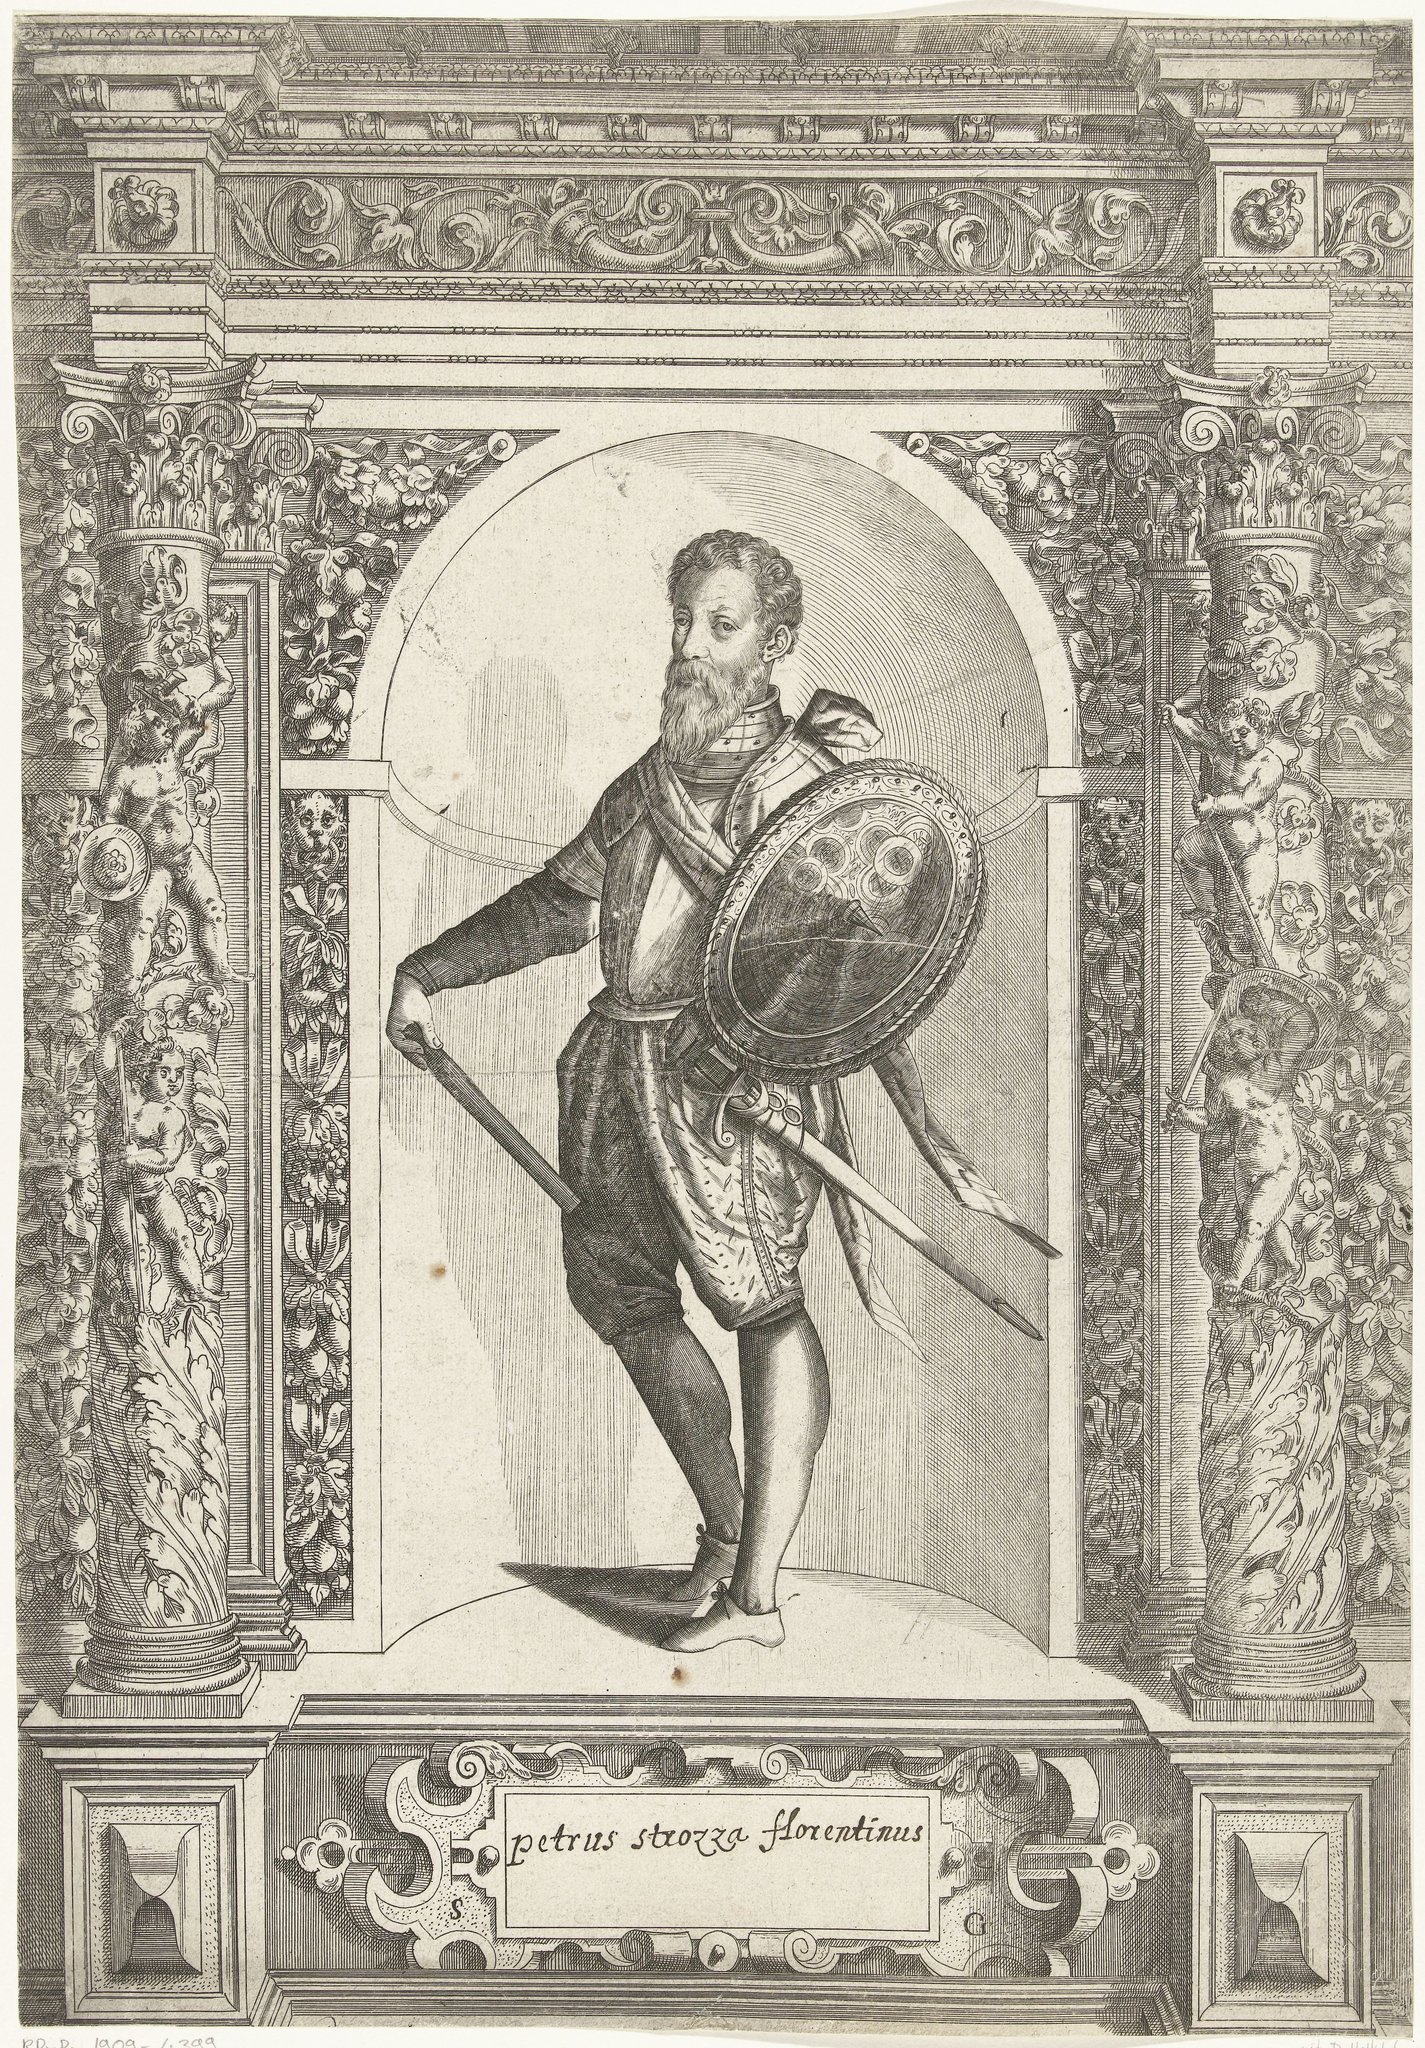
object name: print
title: Portret van Pietro Strozzi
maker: dominicus custos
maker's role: print maker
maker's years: 1560-1615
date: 1582-1601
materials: paper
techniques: engraving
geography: augsburg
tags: pietro strozzi, armour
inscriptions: collector's mark: Lugt 2228, inscription: ‘Petrus Strozza Florentinus’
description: Illustratie uit: Jacob Schrenck von Notzing.Augustissimorum imperatorum, serenissimorum regum atque archiducum, illustrissimorum principum, necnon comitum, baronum, nobilium, aliorumque clarissimorum virorum ... verissimae imagines & rerum ab ipsis ... gestarum succinctae descriptiones. Innsbruck: Daniel Baur [1601], of latere uitgave.